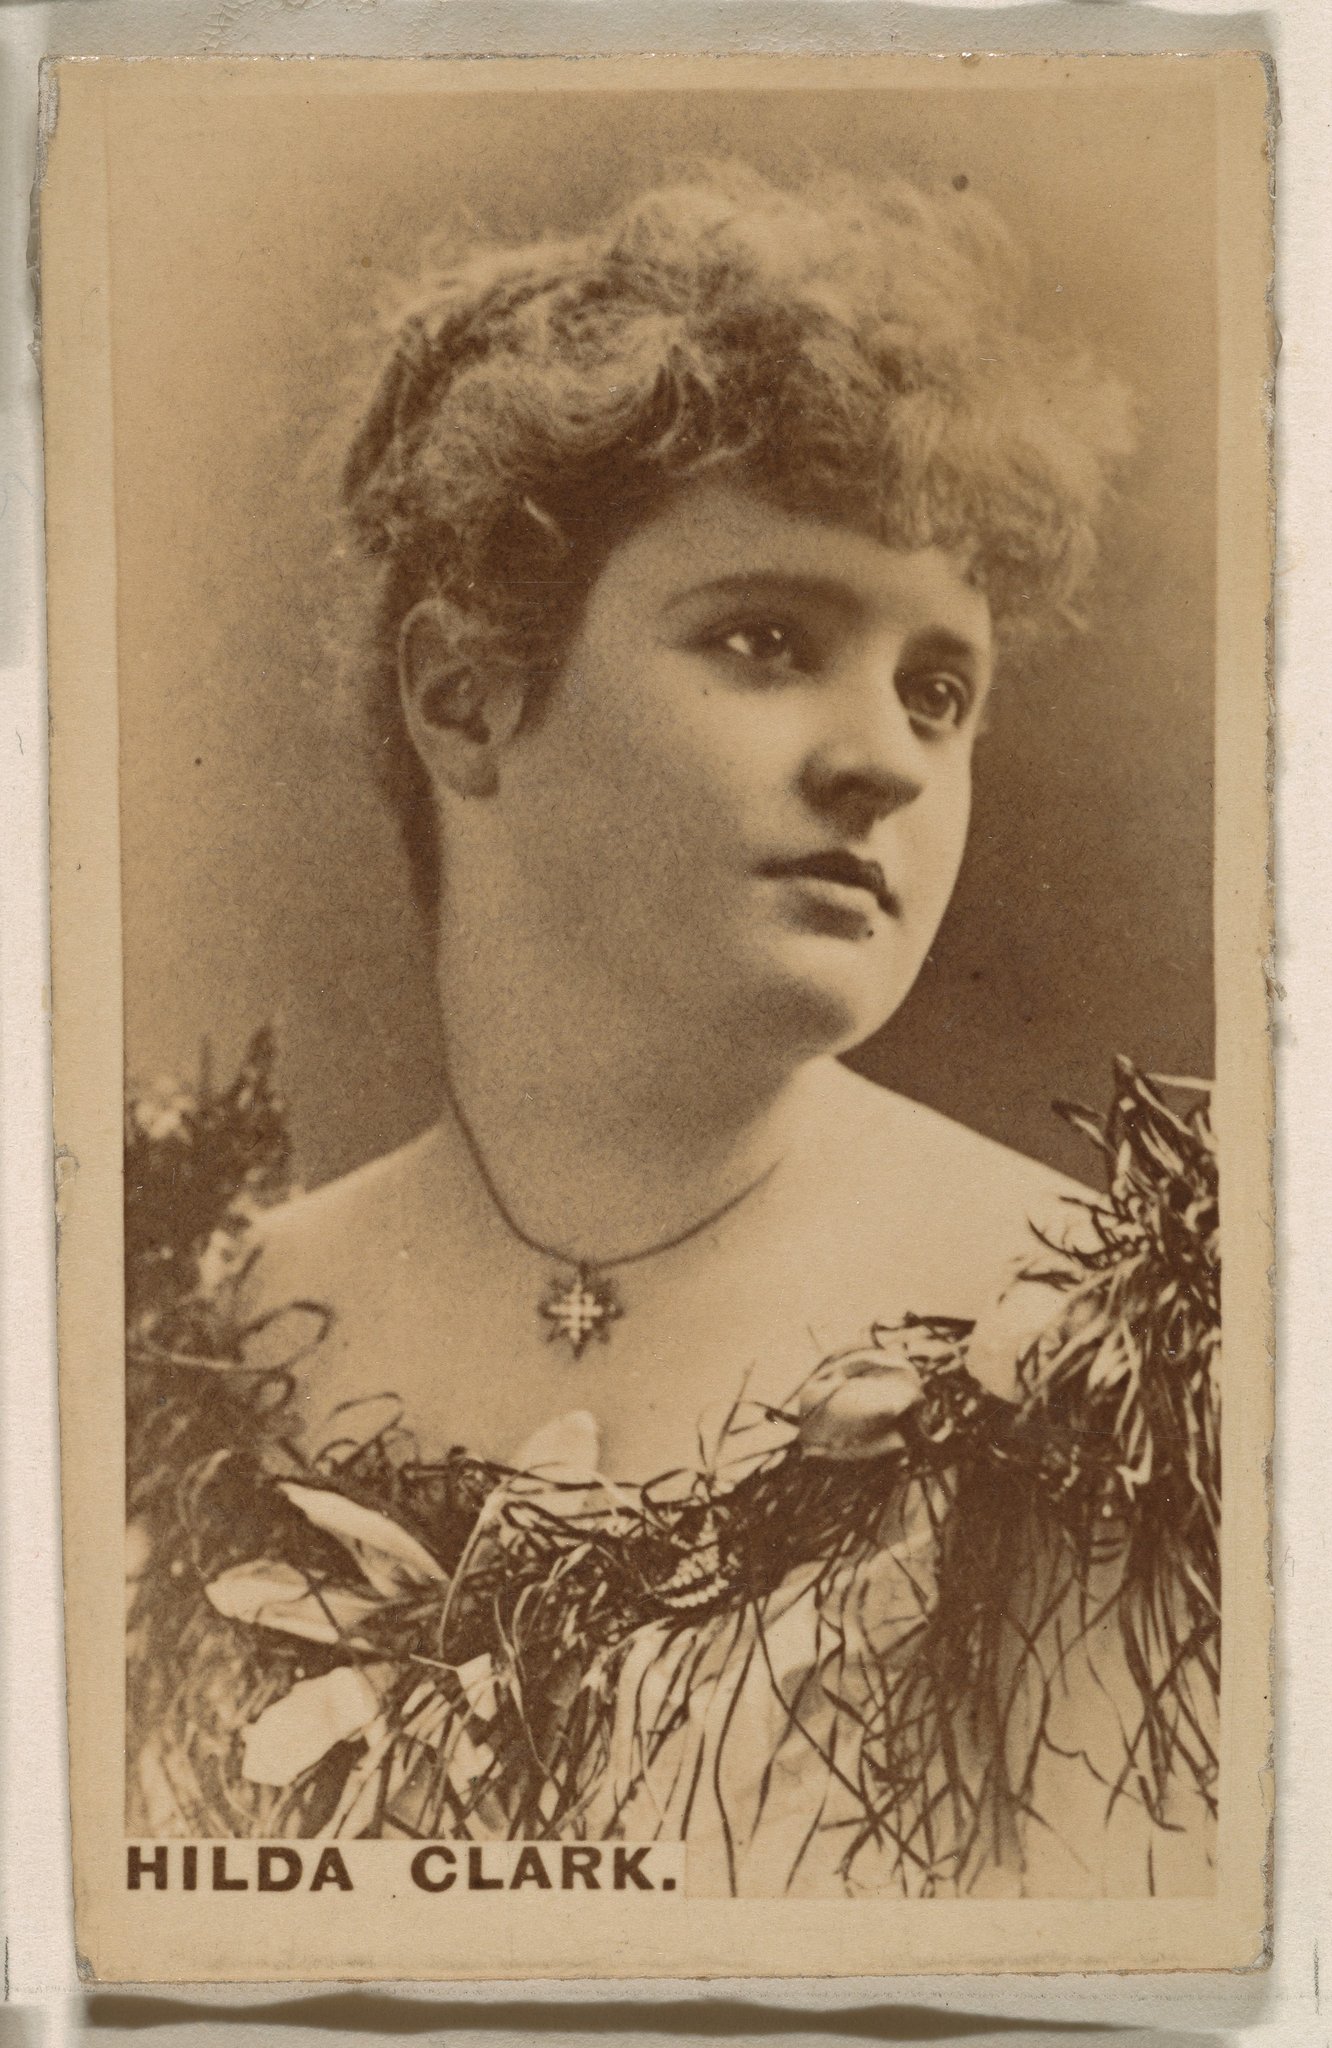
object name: photograph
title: Hilda Clark, from the Actresses series (N246), Type 1, issued by Kinney Brothers to promote Sporting Extra Cigarettes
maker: kinney brothers tobacco company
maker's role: publisher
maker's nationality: american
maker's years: 1869-2011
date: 1890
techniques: albumen silver print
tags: portraits,women,actresses